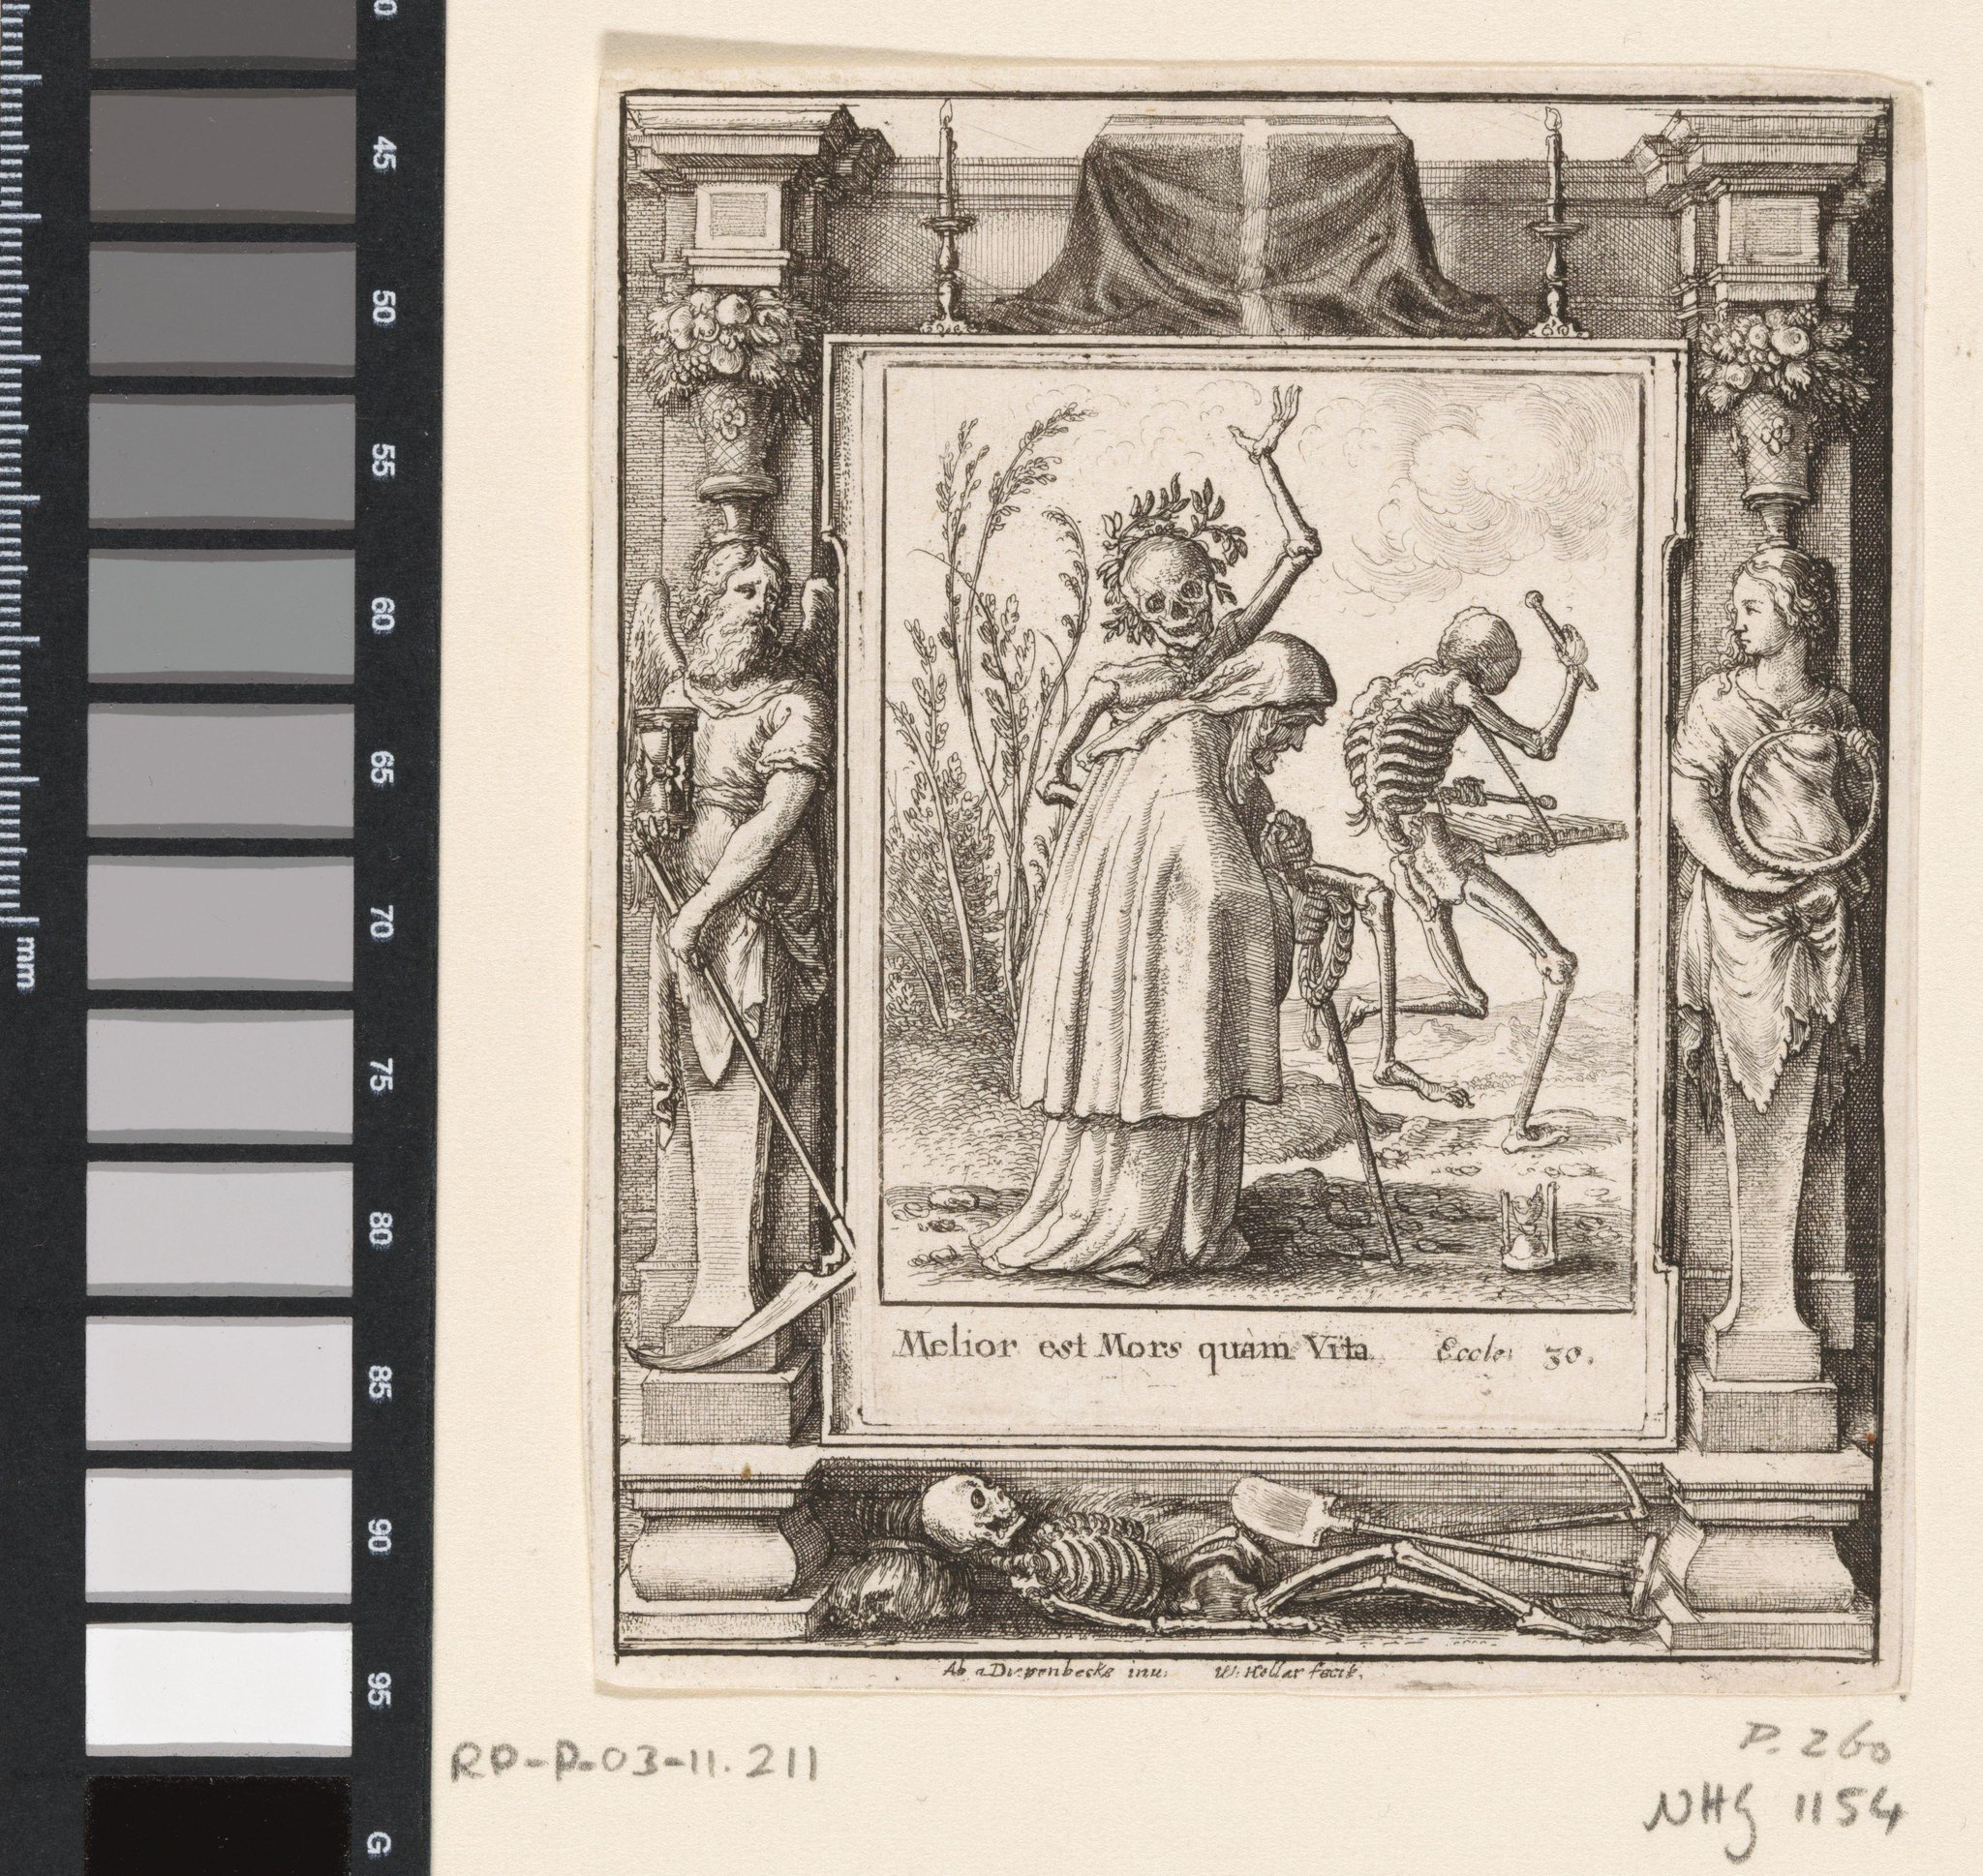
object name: print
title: De oude vrouw en de Dood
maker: wenceslaus hollar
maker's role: draughtsman, print maker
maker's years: 1607-1677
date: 1651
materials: paper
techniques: etching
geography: antwerp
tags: dance of death; death together with one or more human beings, eternity, 'aeternitas'; 'eternità','eternità o perpetuità' (ripa), old woman, father time, man with wings and scythe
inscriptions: collector's mark: Lugt 2228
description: De Dood begeleidt een oude vrouw. Voor haar op de grond staat een gebroken zandloper. 29ste prent uit een reeks van 30 dodendansprenten; met een omlijsting met Tijd en Eeuwigheid.